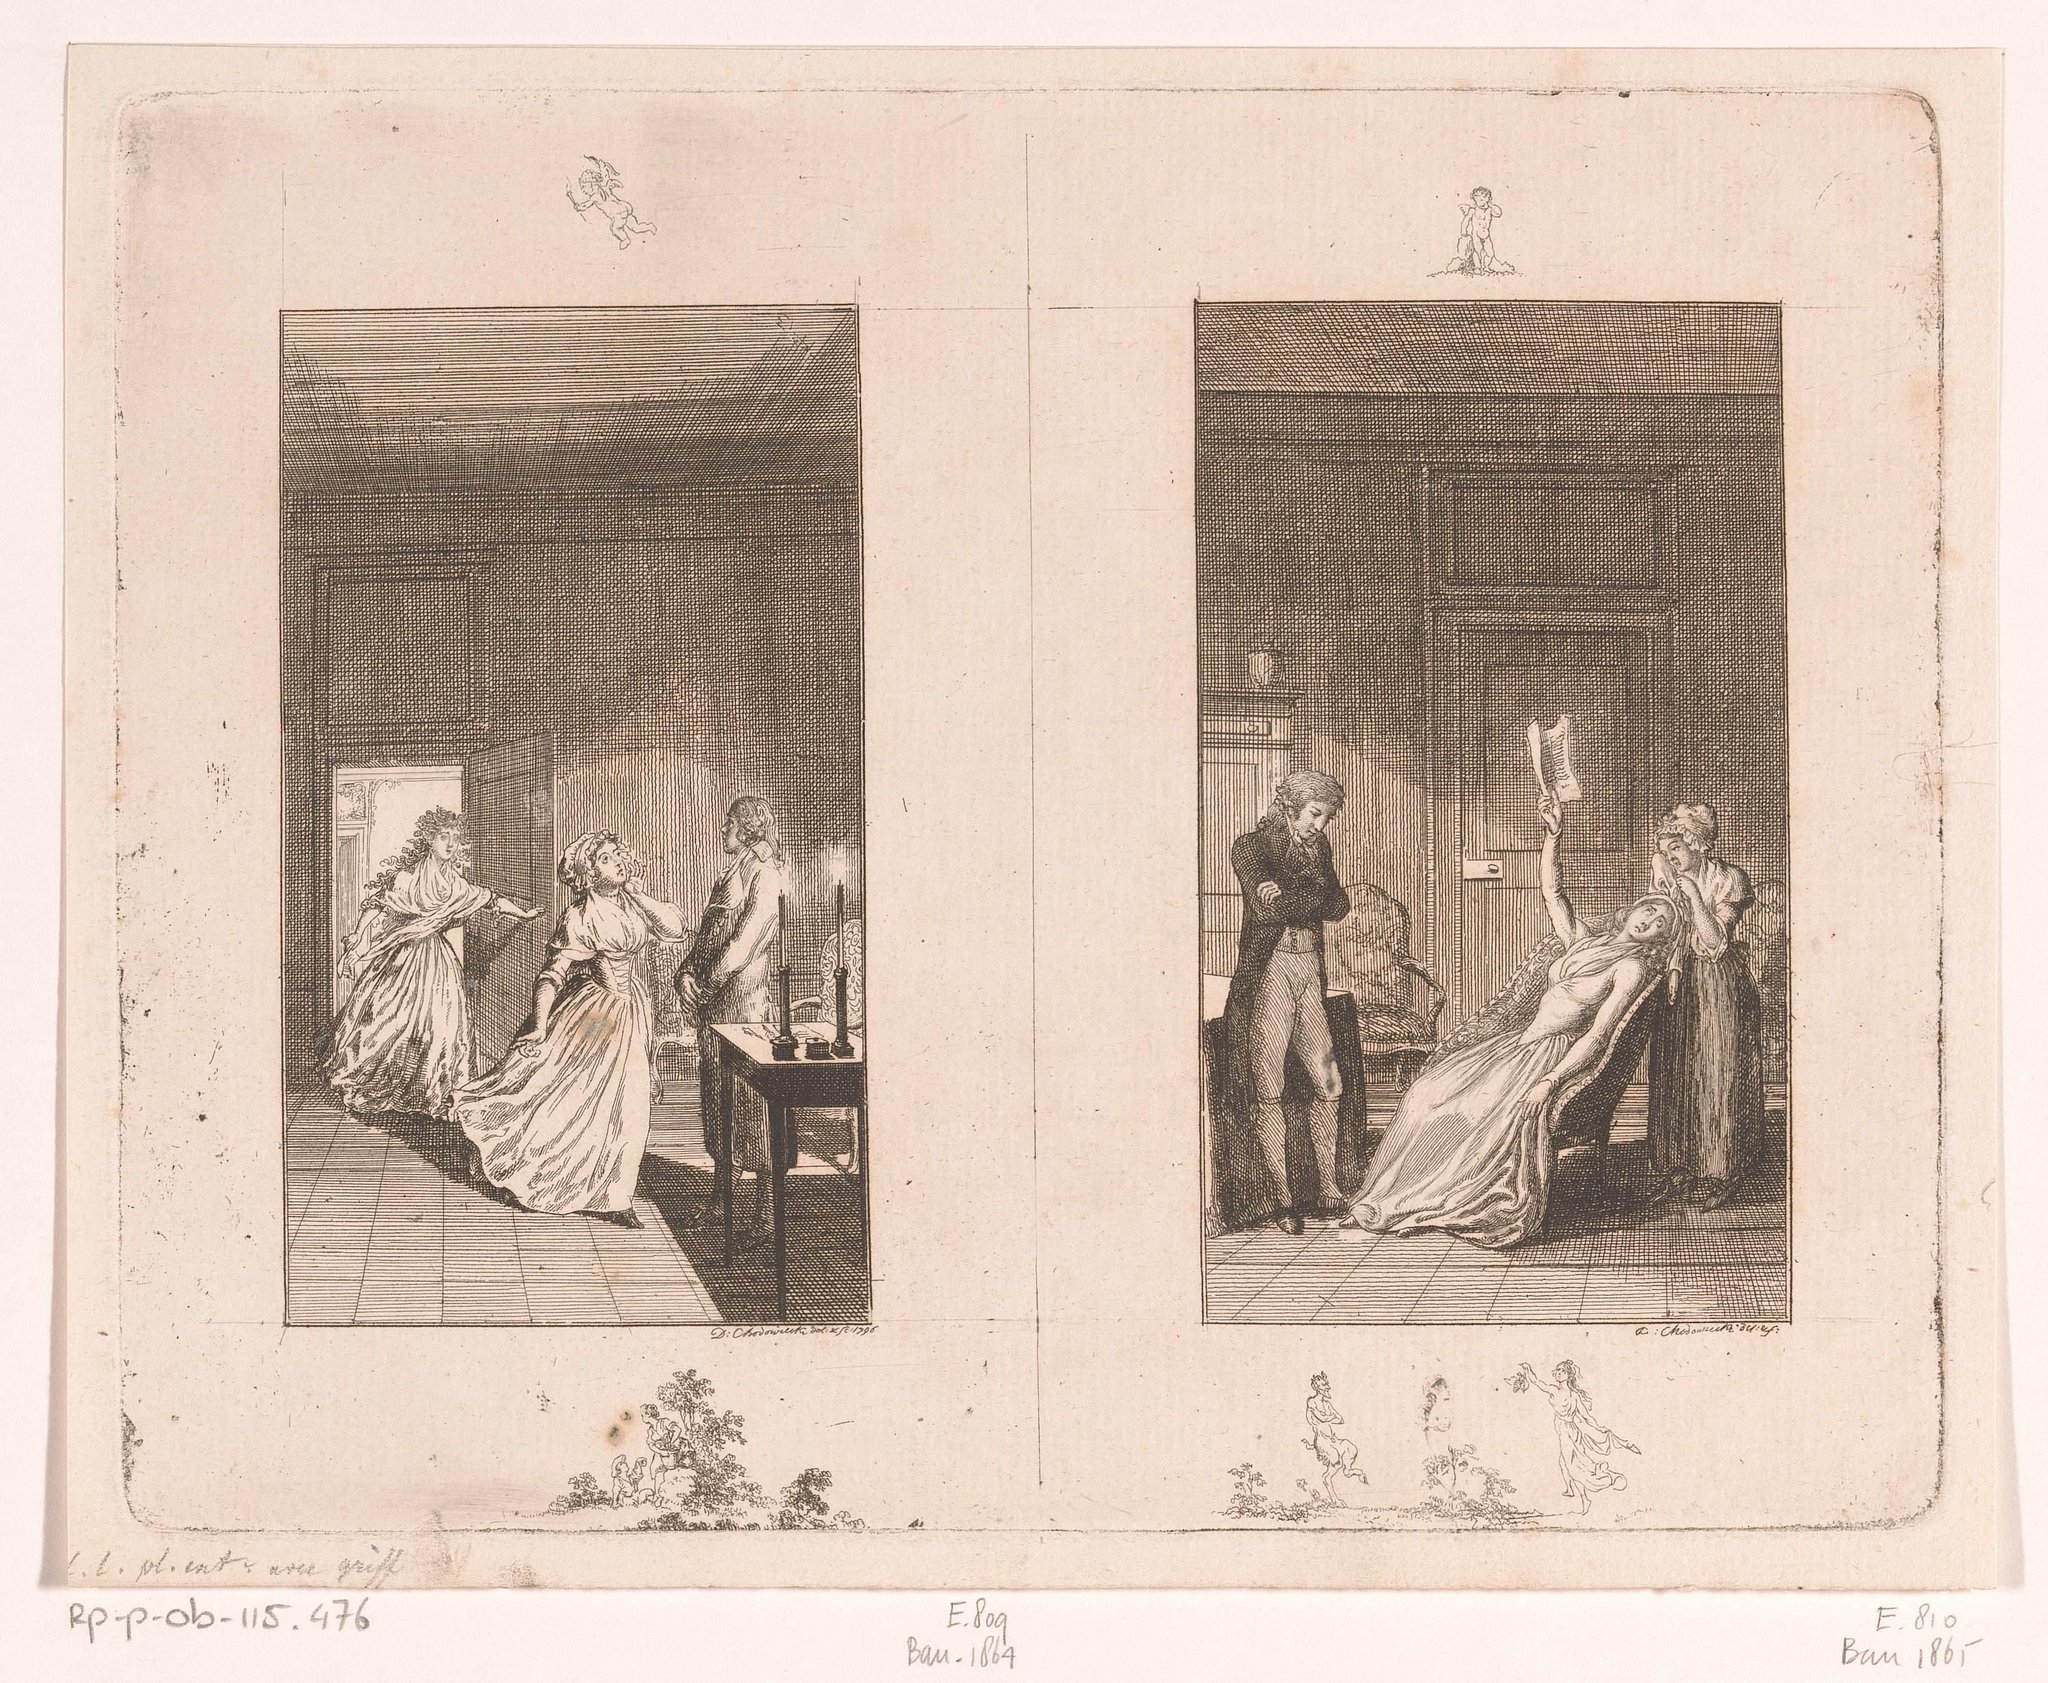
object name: print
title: Twee voorstellingen uit Clarissa van Samuel Richardson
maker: daniel nikolaus chodowiecki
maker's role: draughtsman, print maker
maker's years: 1726-1801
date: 1796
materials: paper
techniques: etching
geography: berlin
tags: fainting, swooning, literature, despair; 'disperatione' (ripa)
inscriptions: collector's mark: Lugt 2228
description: Latere staat gebruikt voor: Richardson, Samuel. Clarissens Schicksale dargestellt in vier und zwanzig Kupferblättern von Daniel Chodowiecki. mit Erläuterungen des Deutschen Uebersetzers Dr. L. Th. Kosegarten. Leipzig: Heinrich Gräff, 1796.